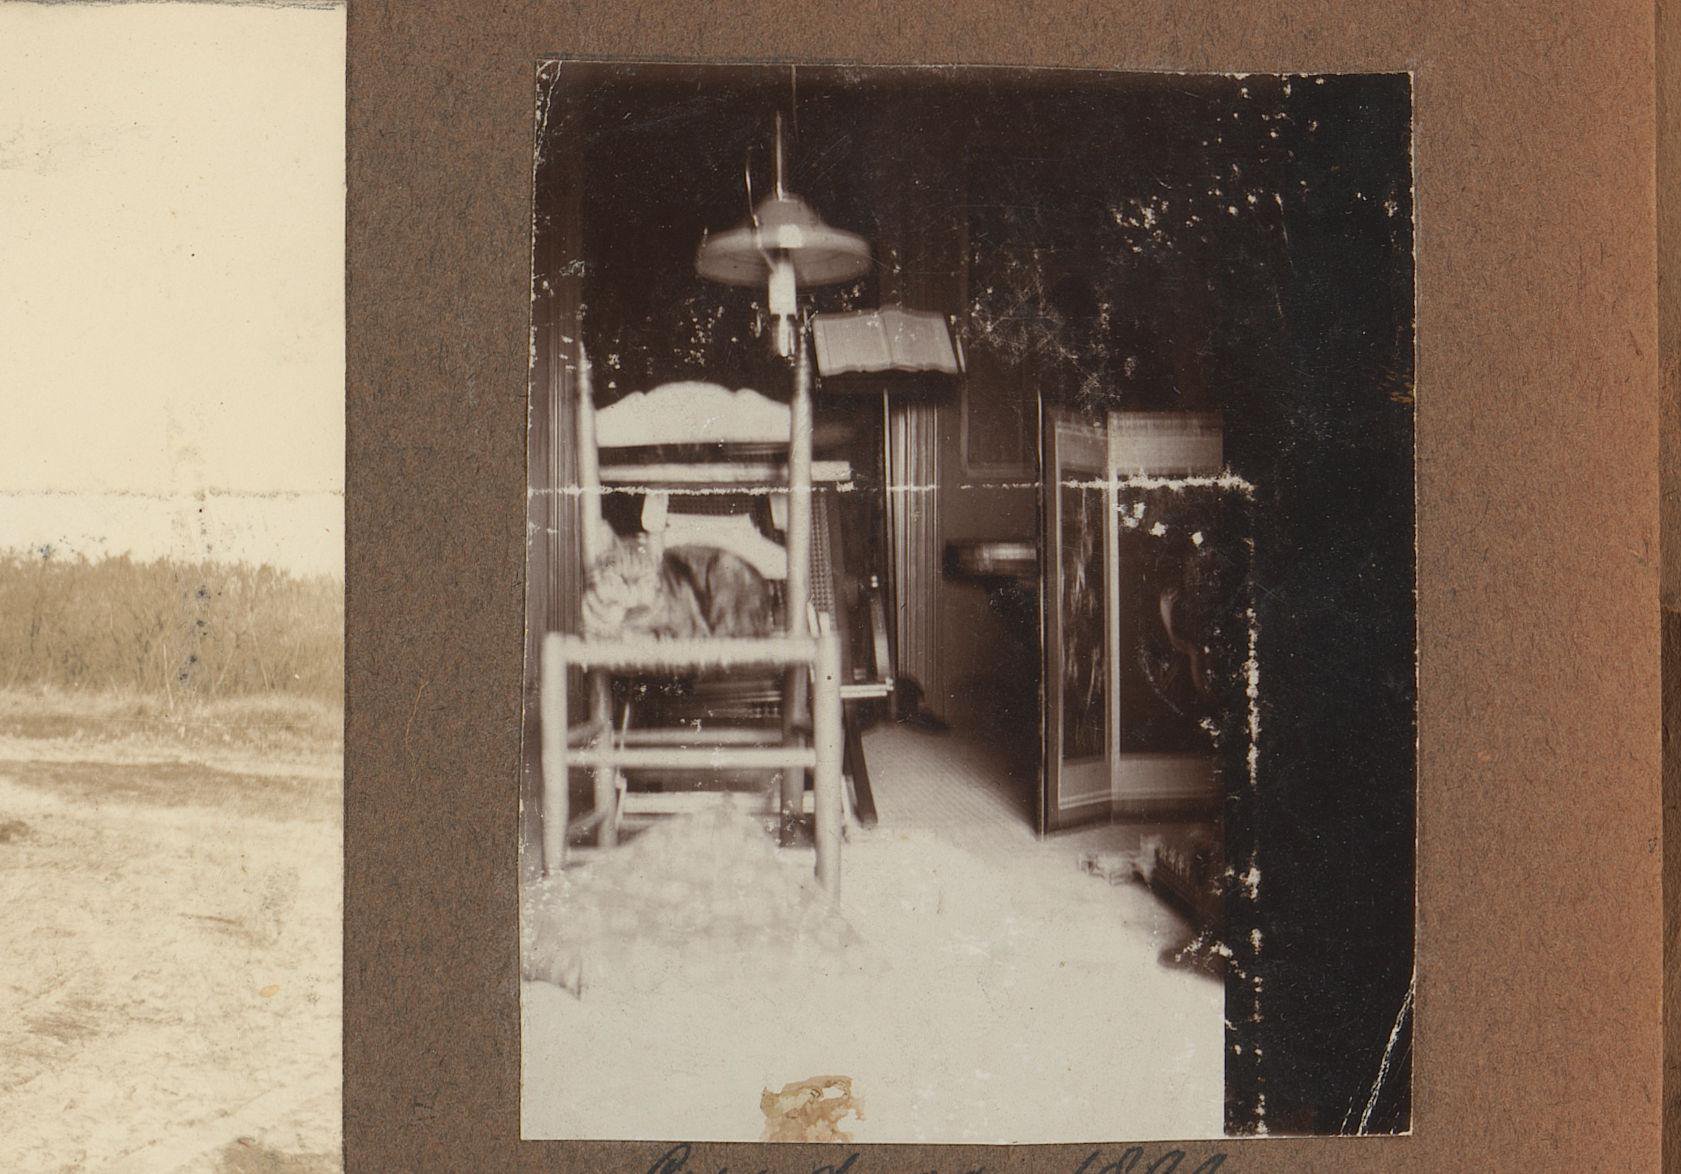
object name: photograph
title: Poes Goudoog op stoel in interieur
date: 1899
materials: photographic support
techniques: collodion silver print, pasting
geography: netherlands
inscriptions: date: ‘1912.’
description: Foto op bruin albumblad 11 van familiealbum van Alphons Diepenbrock.